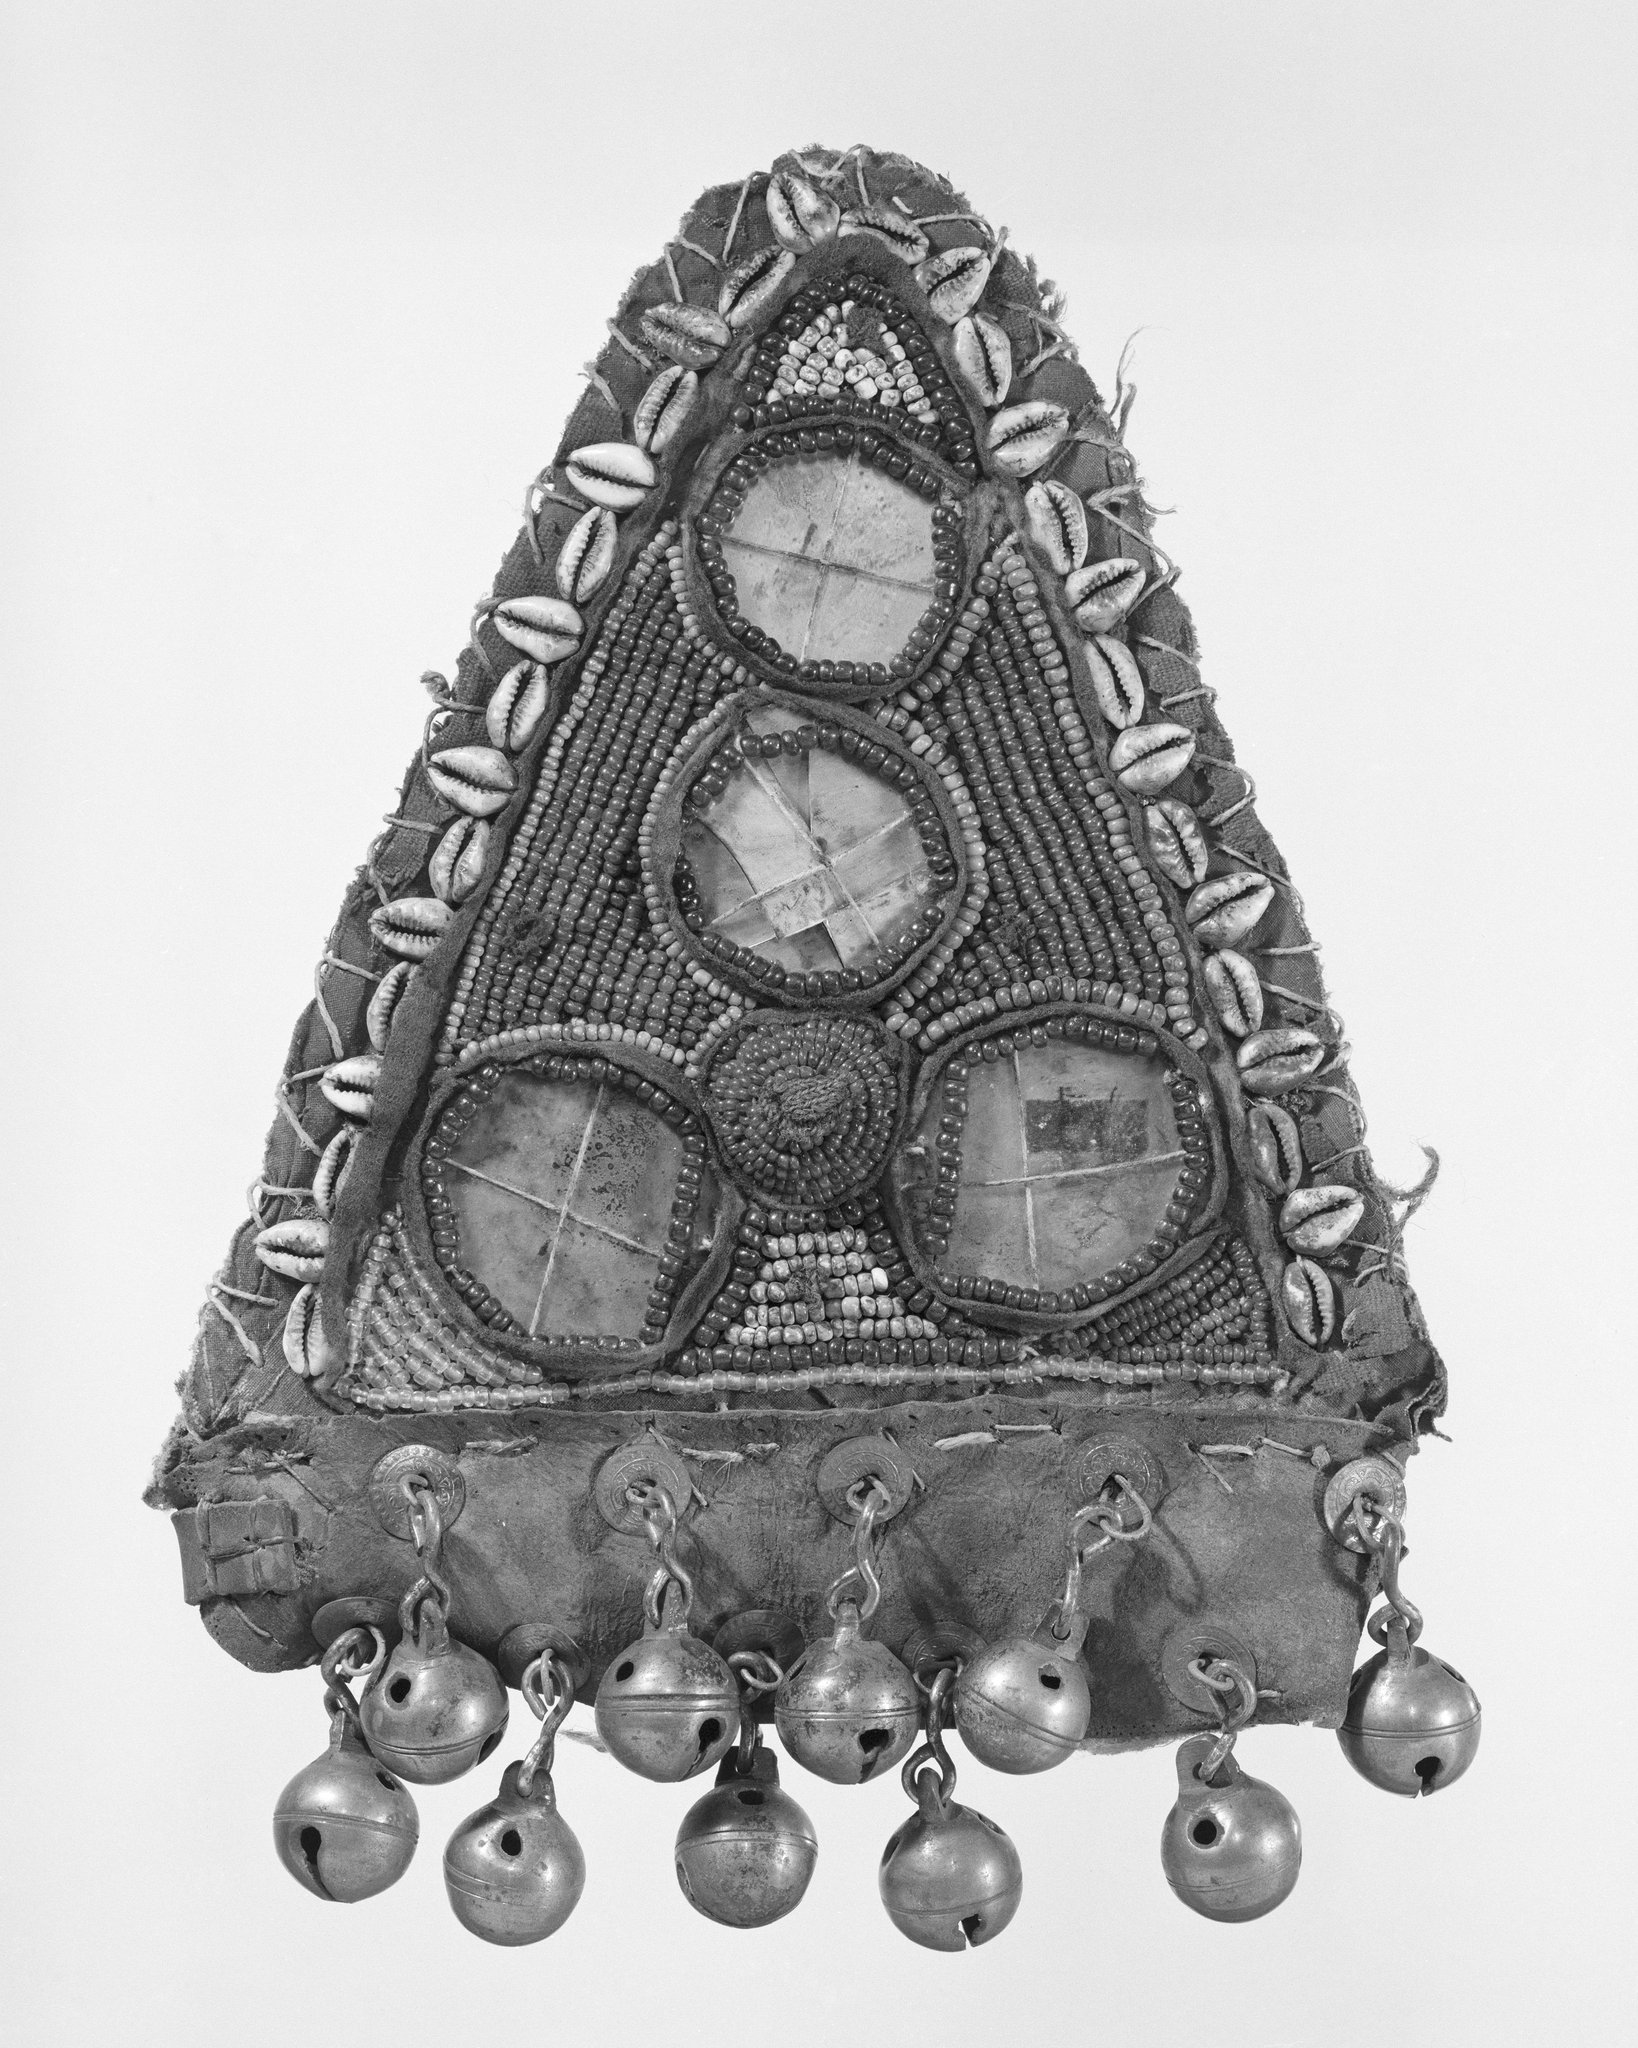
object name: guard rattle with bell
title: Guard Rattle with Bells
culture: syrian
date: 1867-1900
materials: textile, glass, leather, shell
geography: syria